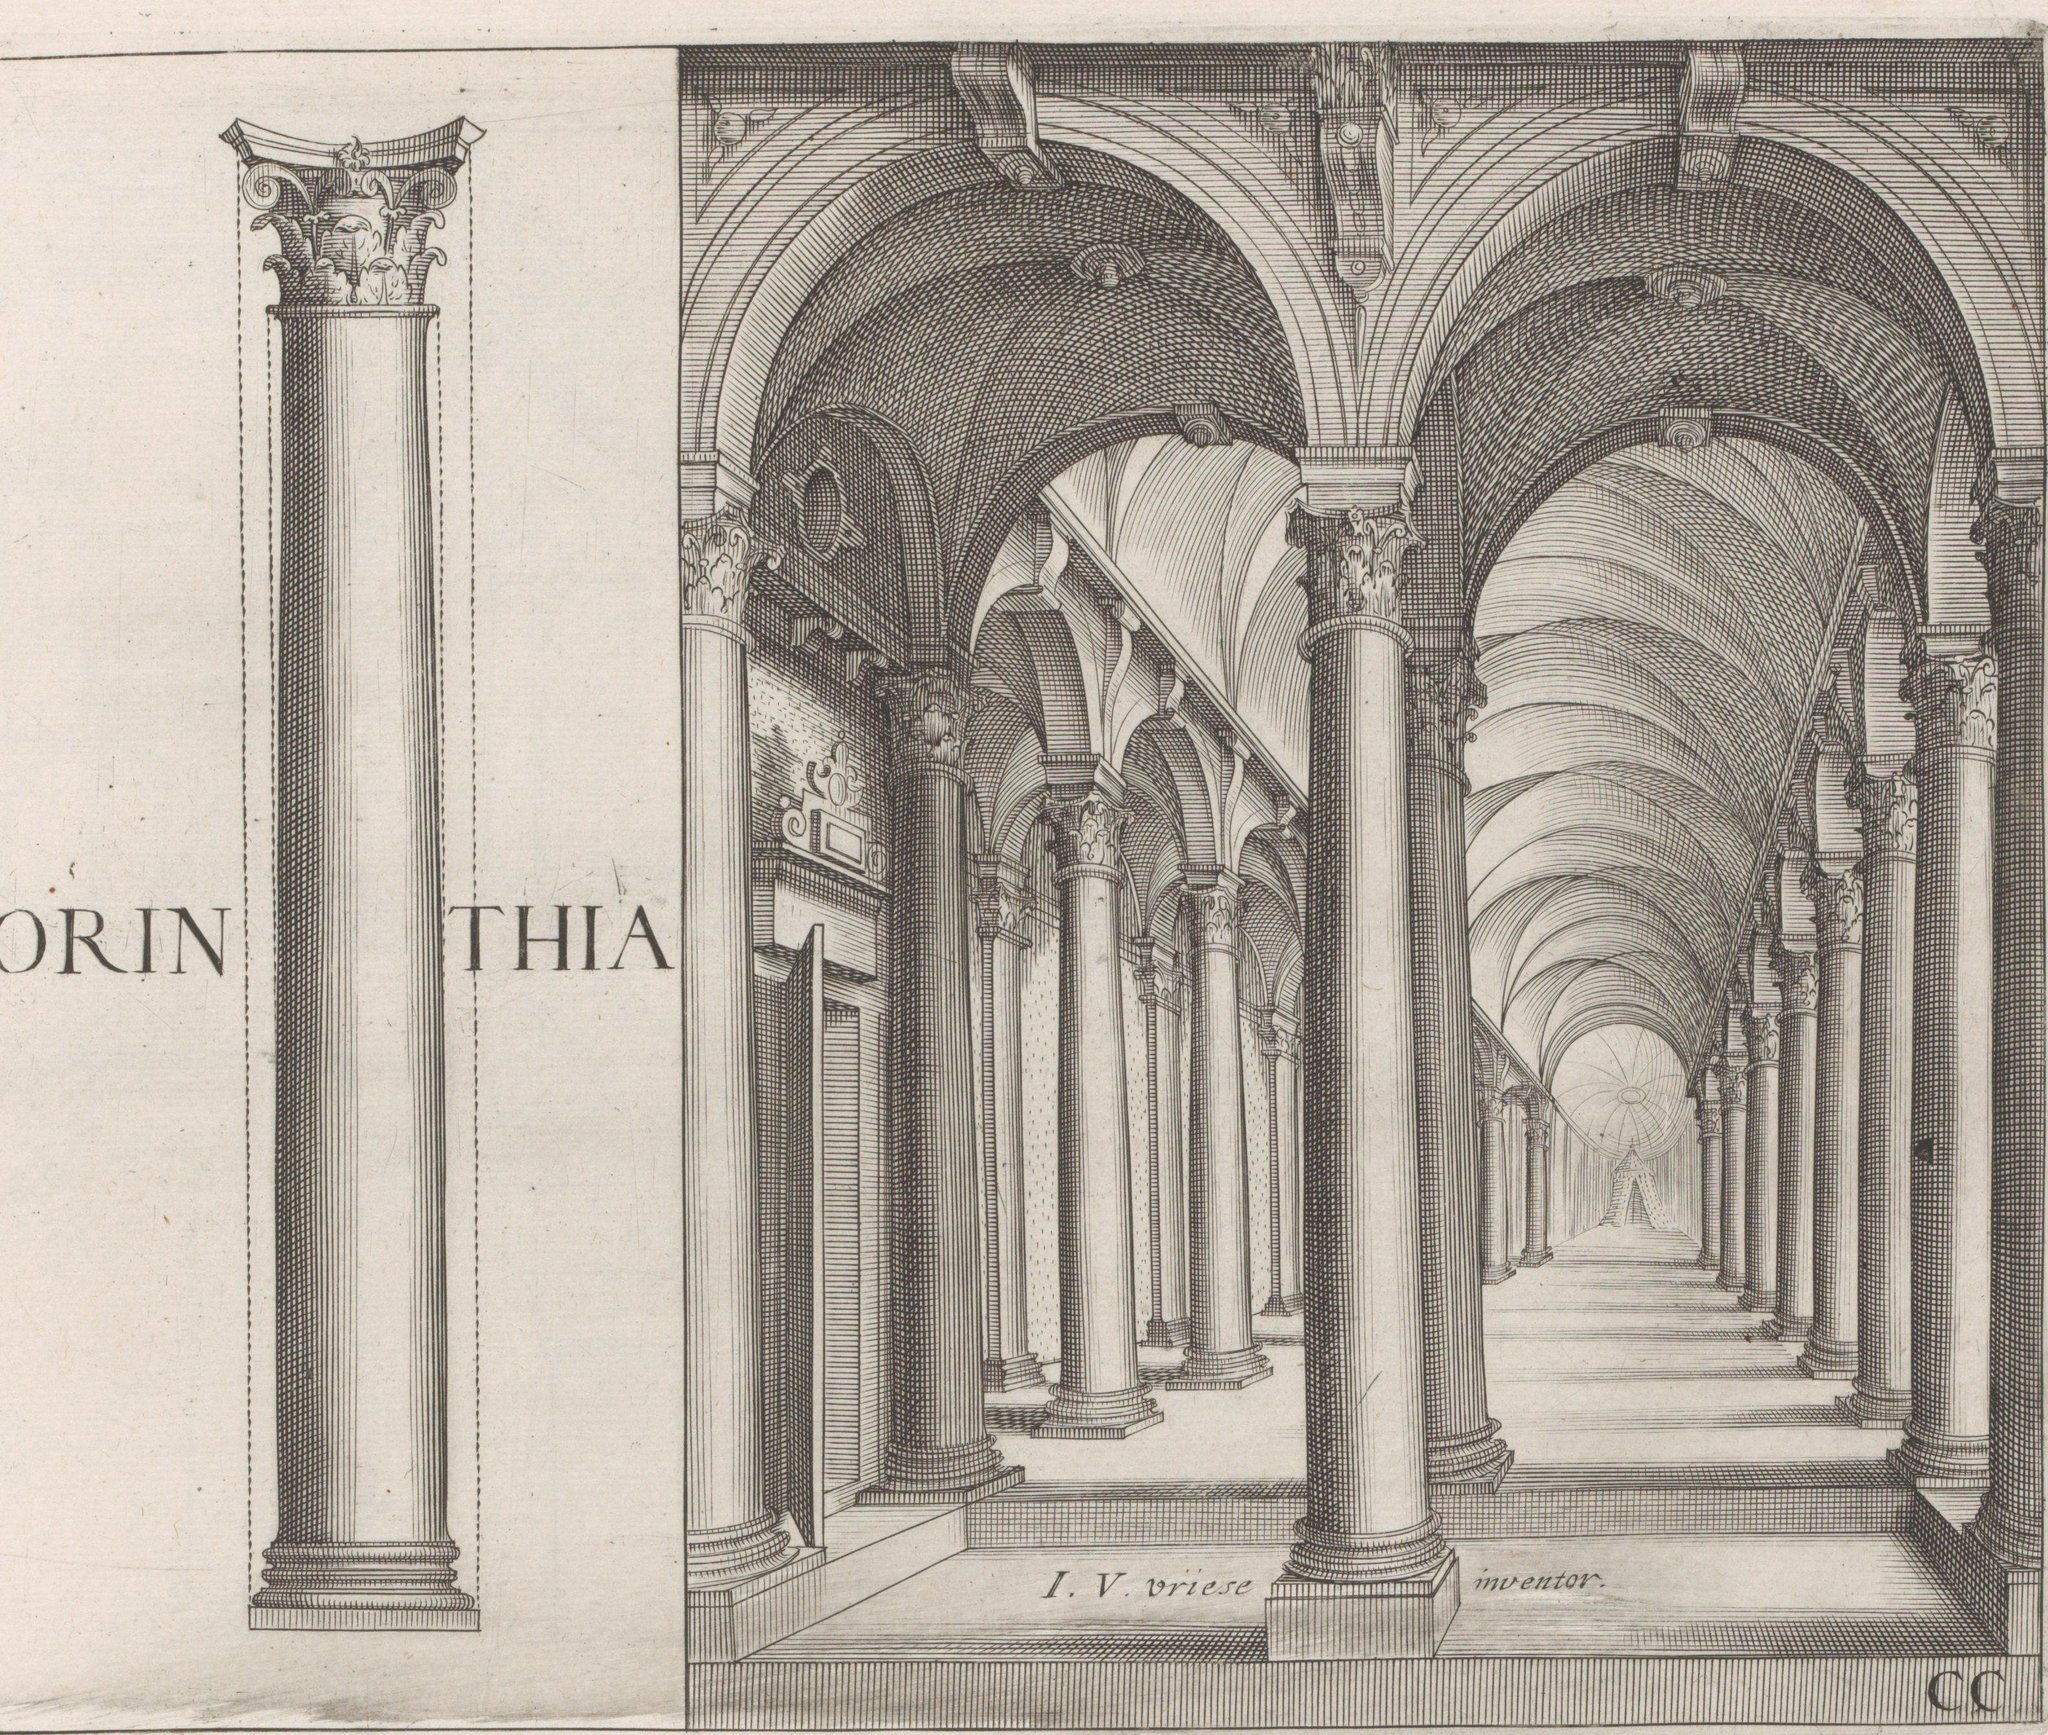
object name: print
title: Architectura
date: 1606-1607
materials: paper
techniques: engraving, etching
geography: amsterdam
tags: colonnade, corinthian order ~ architecture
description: Zuil van de Korinthische orde en een zuilengang met zuilen van de Korinthische bouworde. Rechtsonder: CC. Prent maakt deel uit van een album.